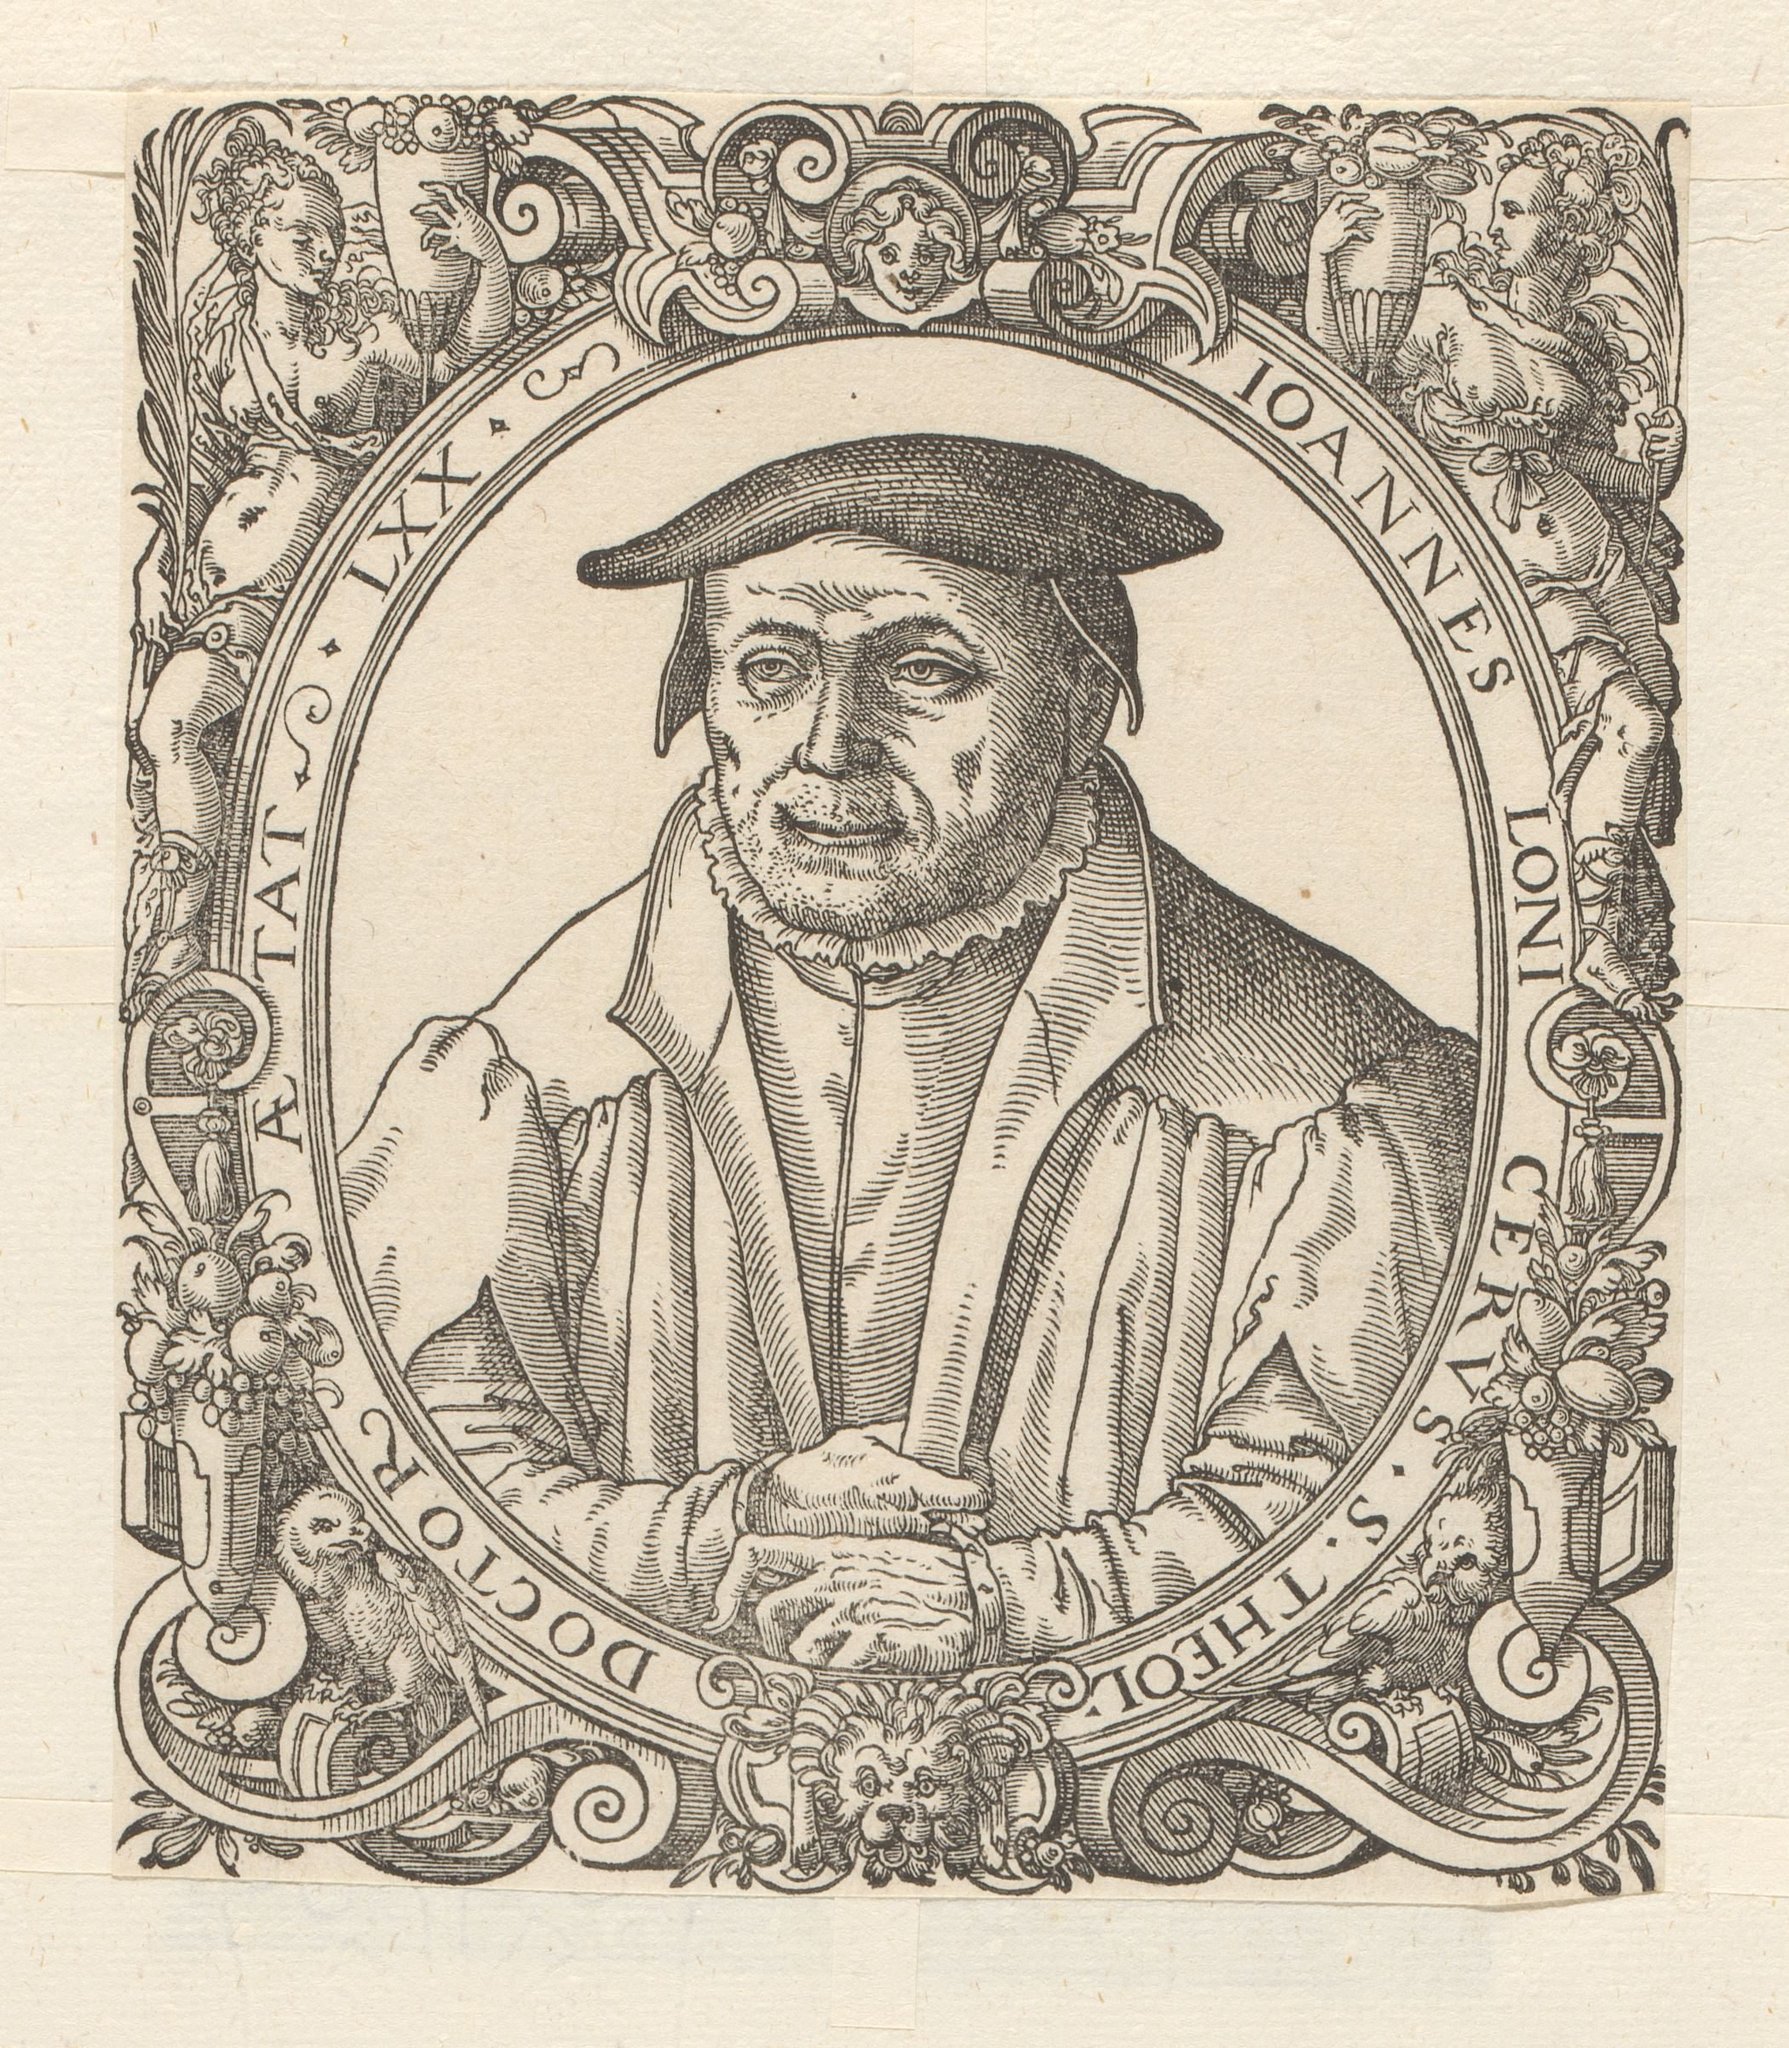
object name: print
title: Portret van Johannes Lonicer op 70-jarige leeftijd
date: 1567-1584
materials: paper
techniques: woodcut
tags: theologian, historical persons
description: Rijkversierde omlijsting. Prent maakt deel uit van een album.